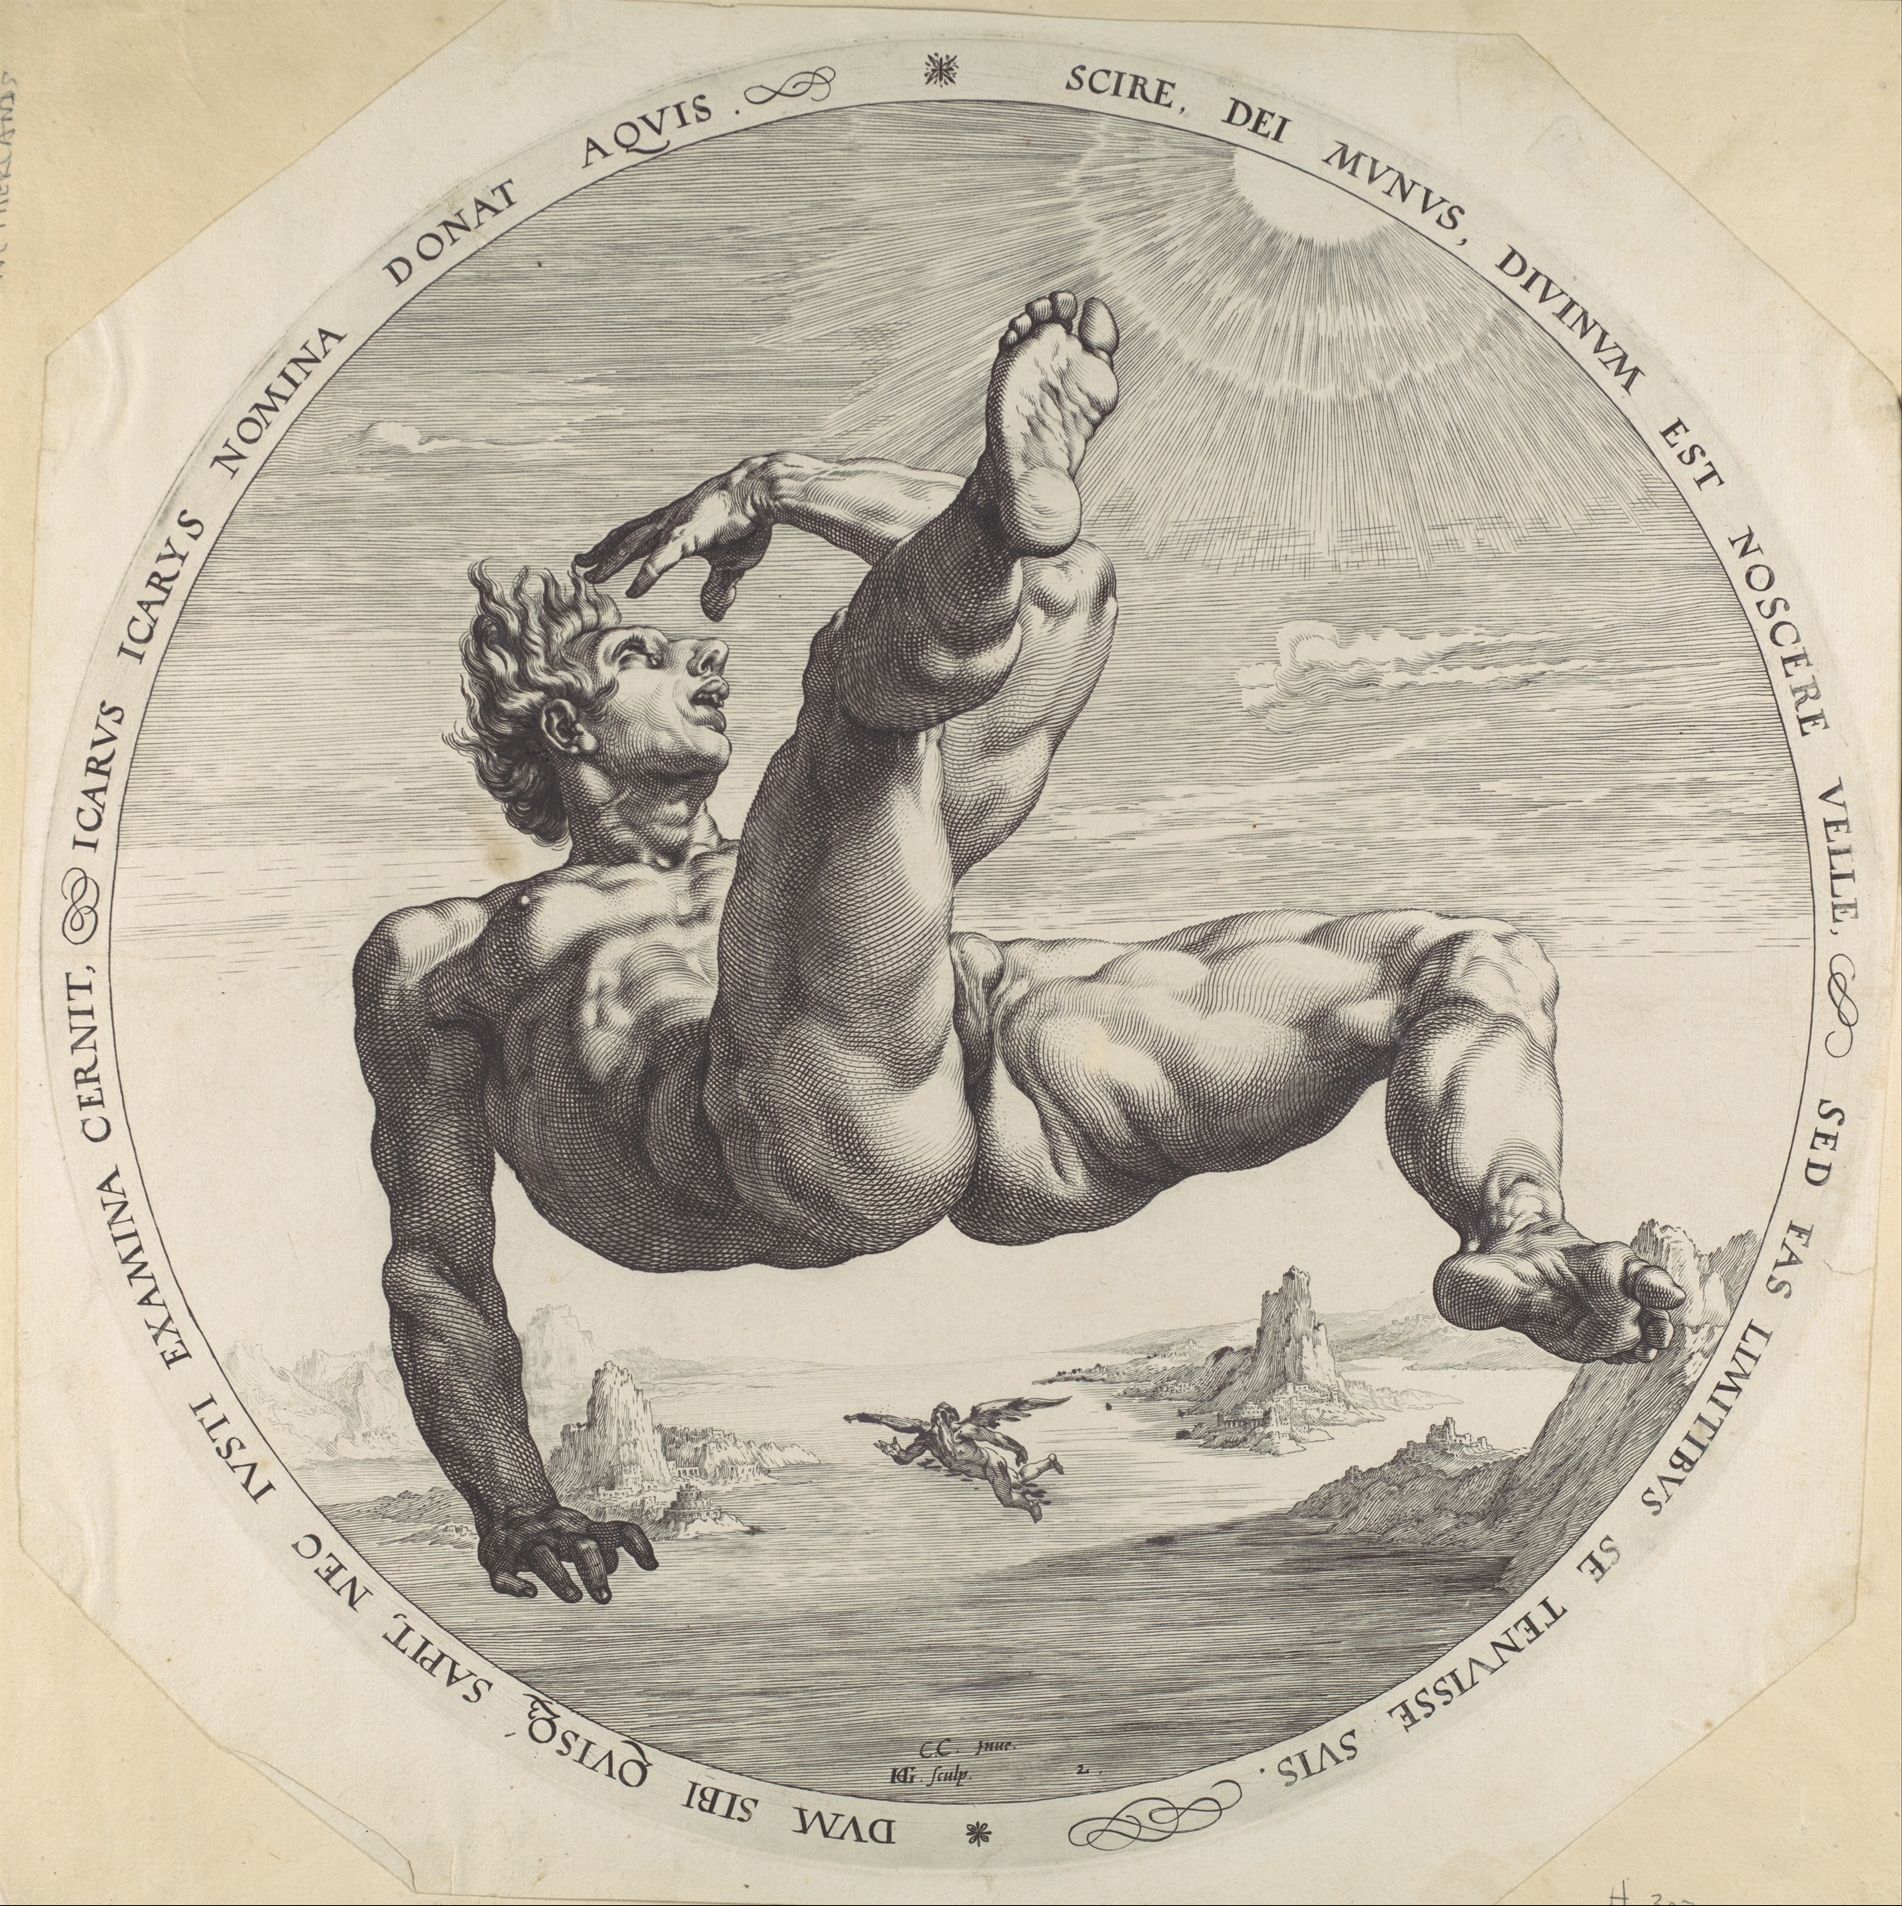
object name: print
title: Icarus, from "The Four Disgracers"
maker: hendrick goltzius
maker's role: artist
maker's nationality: netherlandish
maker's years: 1558-1617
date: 1588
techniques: engraving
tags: male nudes,sun